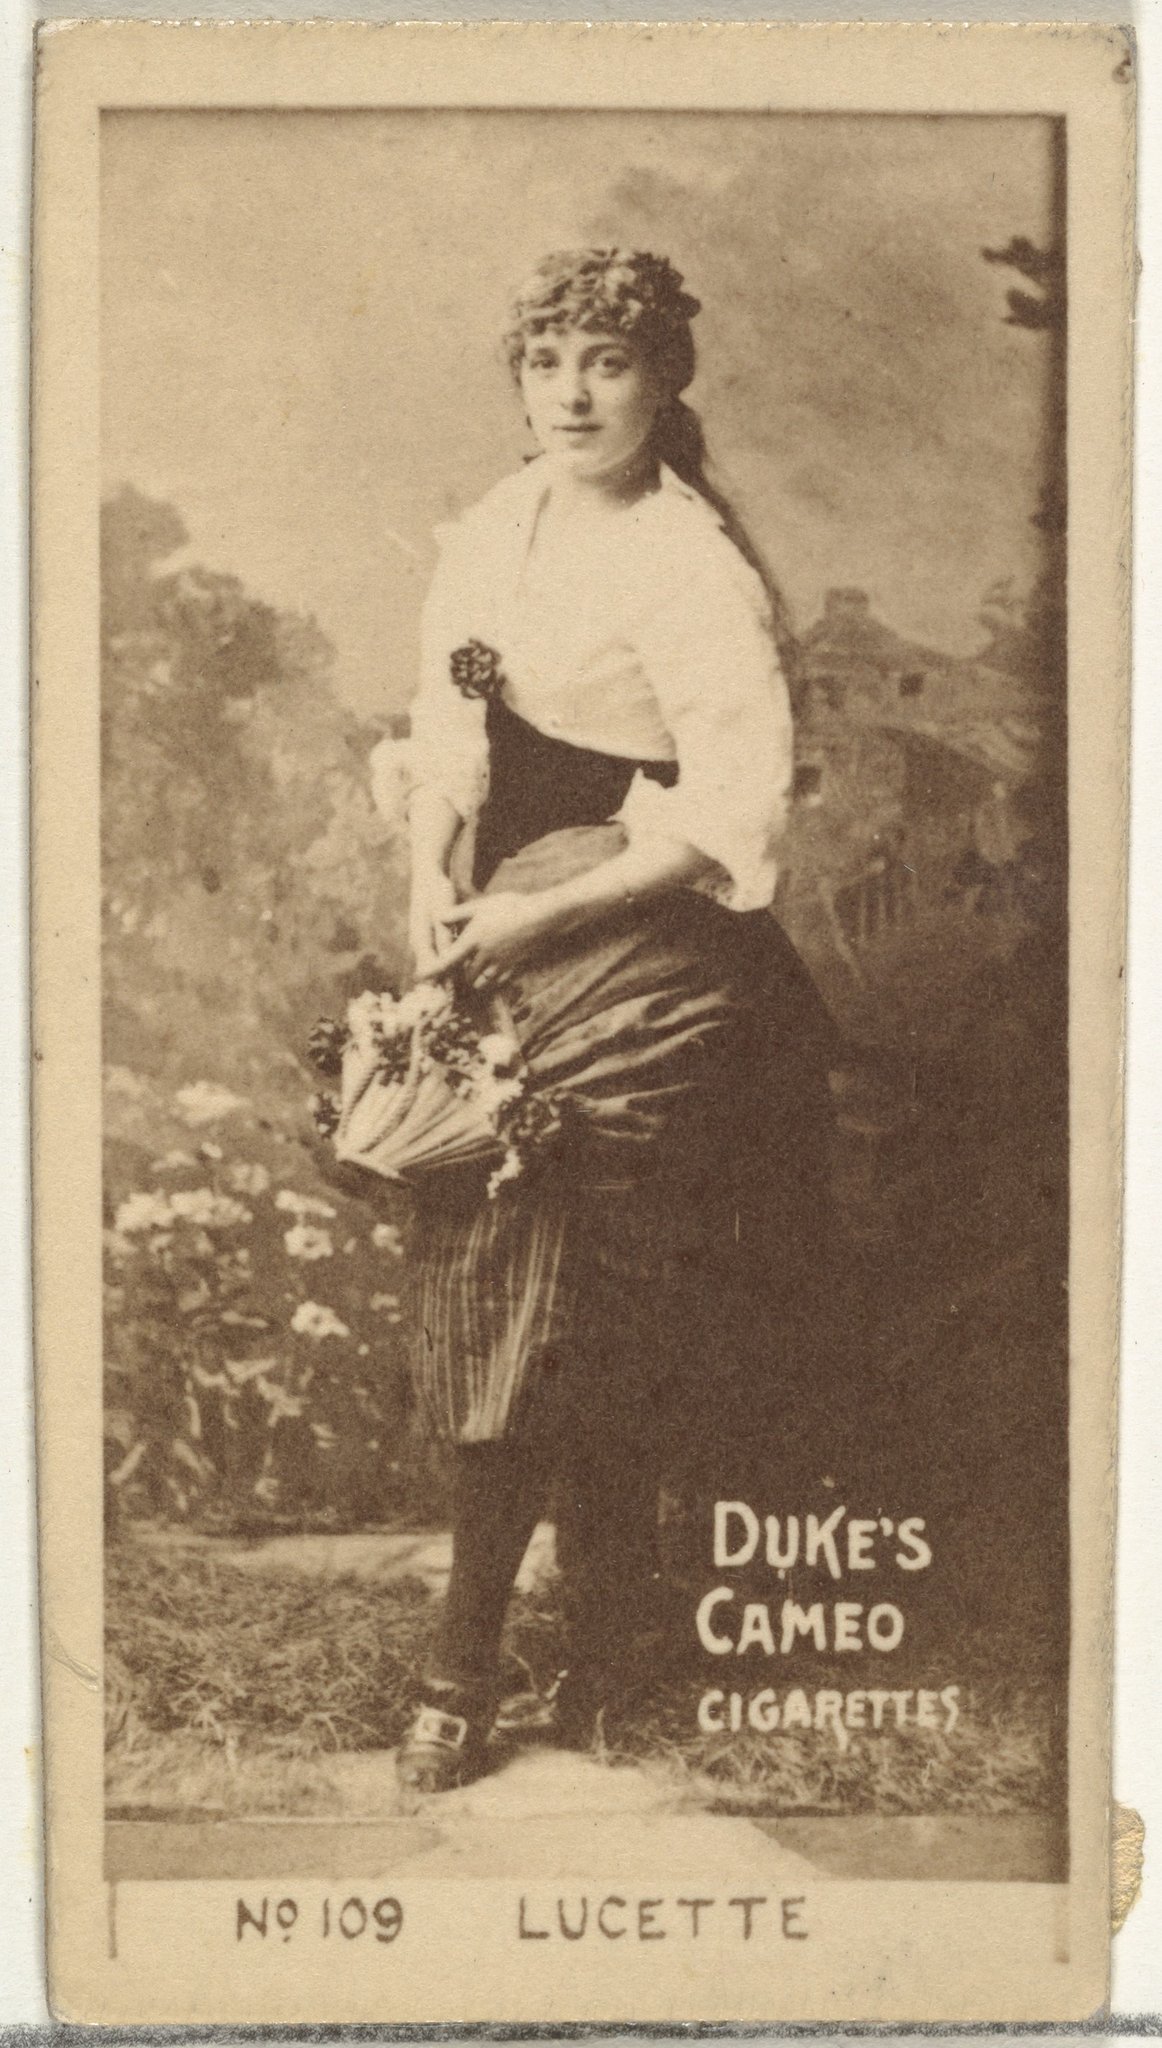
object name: photograph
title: Card Number 109, Lucette, from the Actors and Actresses series (N145-4) issued by Duke Sons & Co. to promote Cameo Cigarettes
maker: w. duke, sons & co.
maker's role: publisher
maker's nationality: american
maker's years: 1870-1920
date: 1880-1889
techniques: albumen silver print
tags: portraits,women,actresses